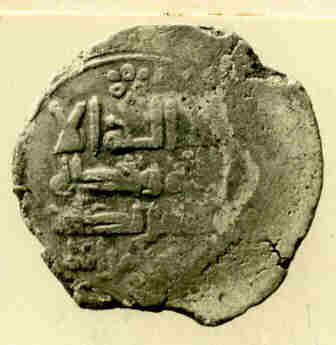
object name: coin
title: Silver coin (dirham) of Tuhril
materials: silver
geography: iran